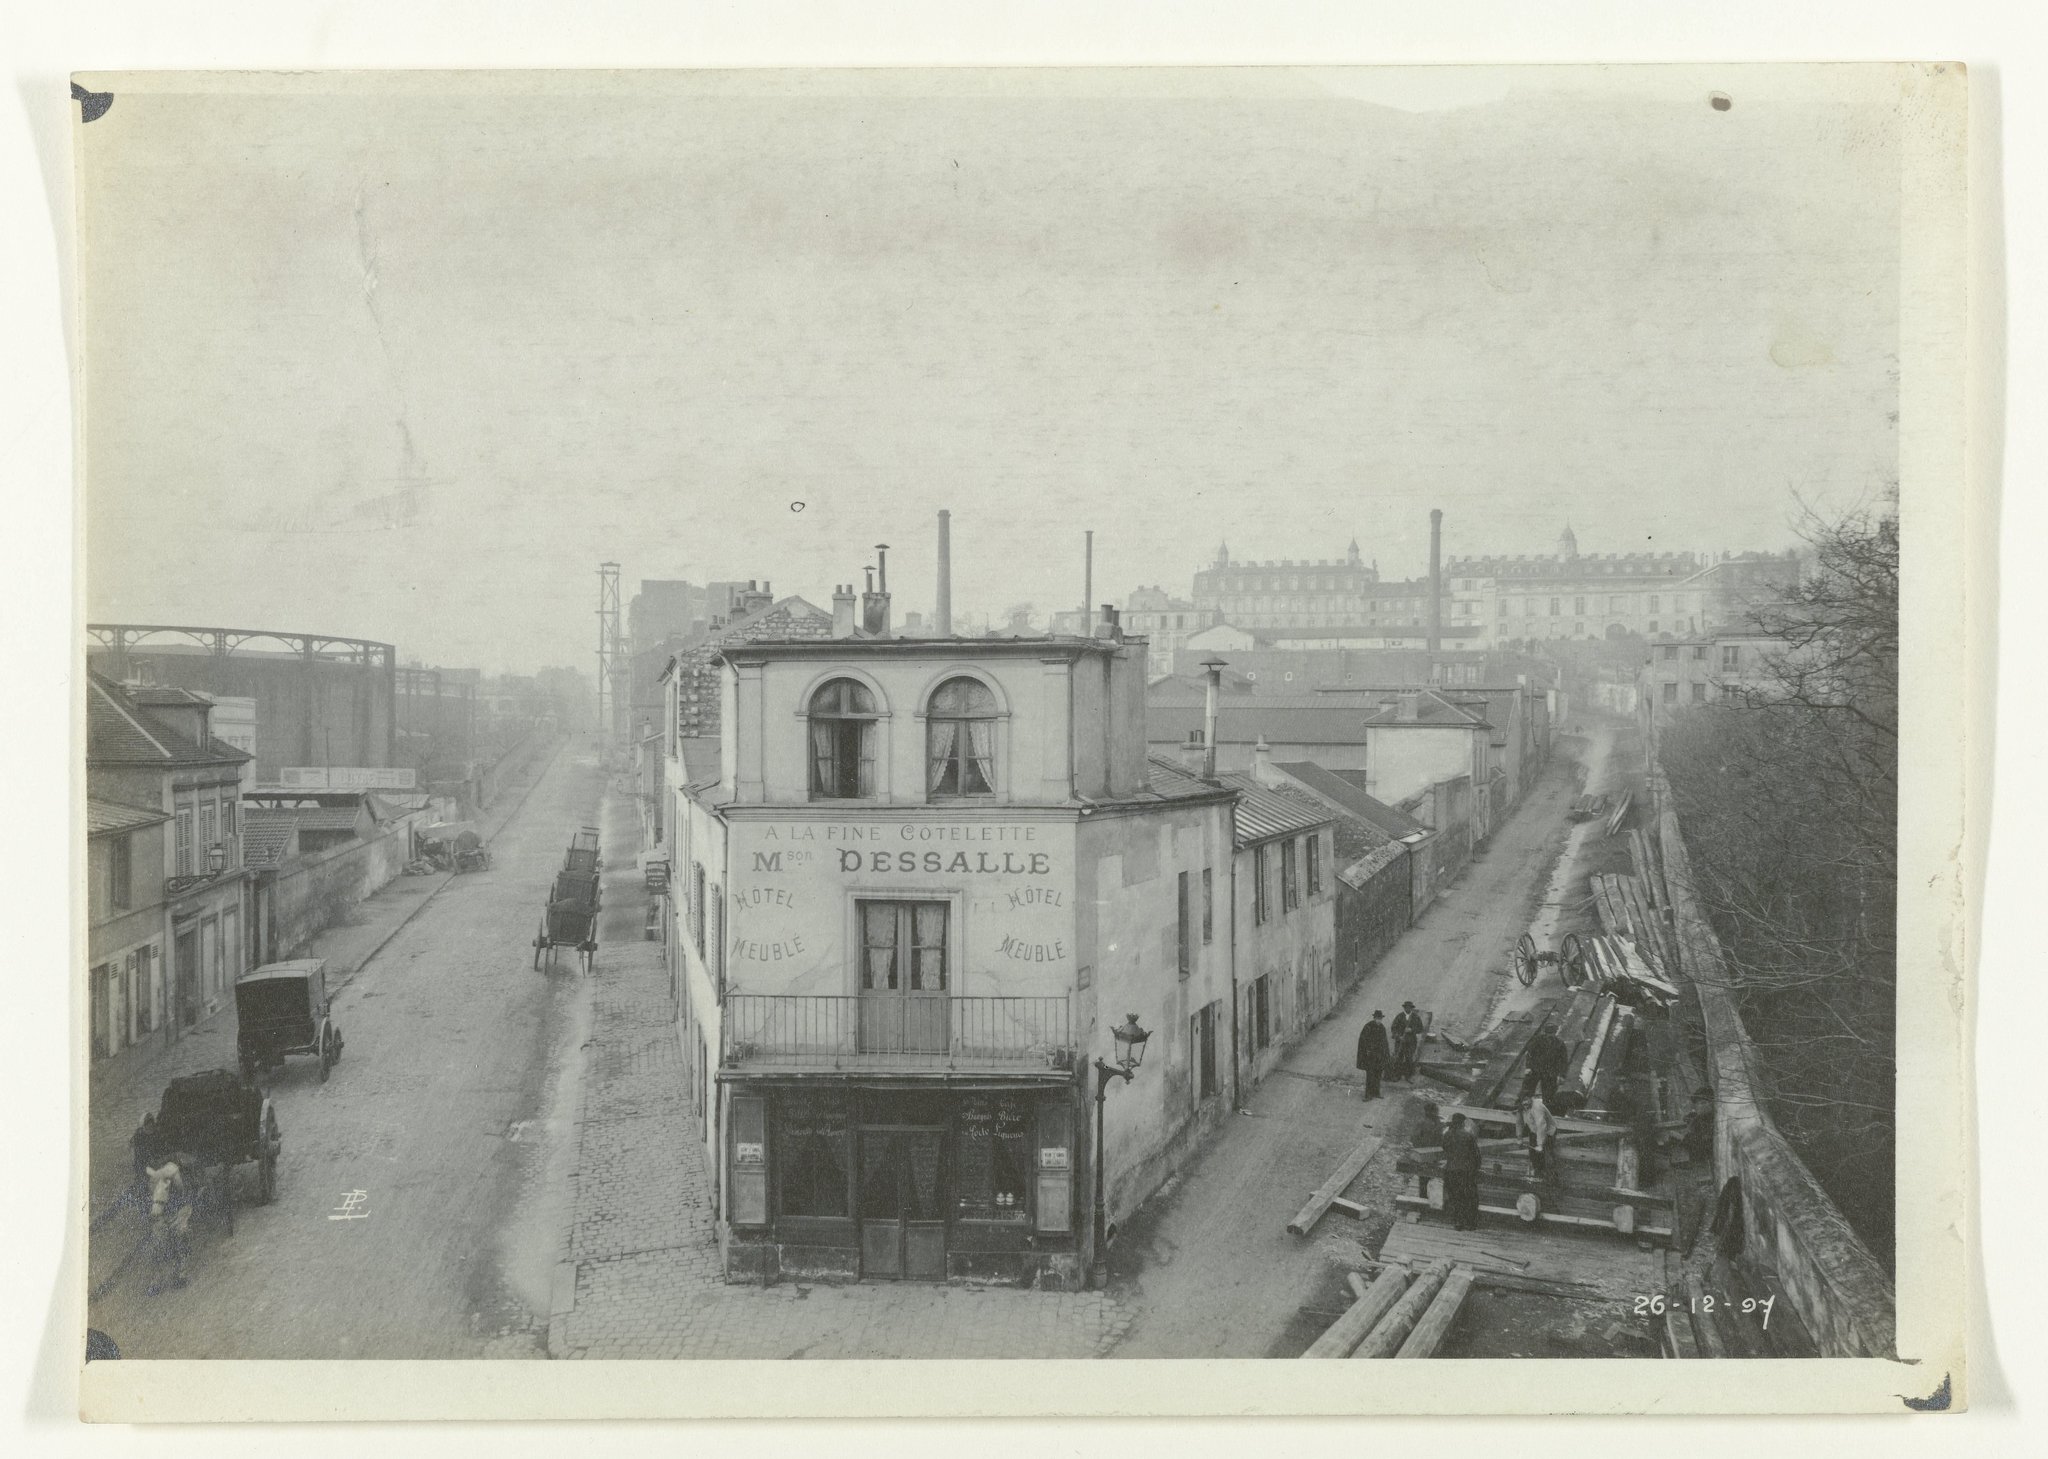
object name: photograph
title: Gezicht op twee straten en een hotel, met werkzaamheden voor de aanleg van de metro in Parijs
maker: emmanuel l. pottier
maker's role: fotograaf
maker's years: 1864-1921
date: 1897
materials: paper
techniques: gelatin silver print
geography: paris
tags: underground railway, 'métro', building-site, street, paris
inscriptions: number: ‘64’, monogram: ‘L.P.’, date: ‘26-12-97’